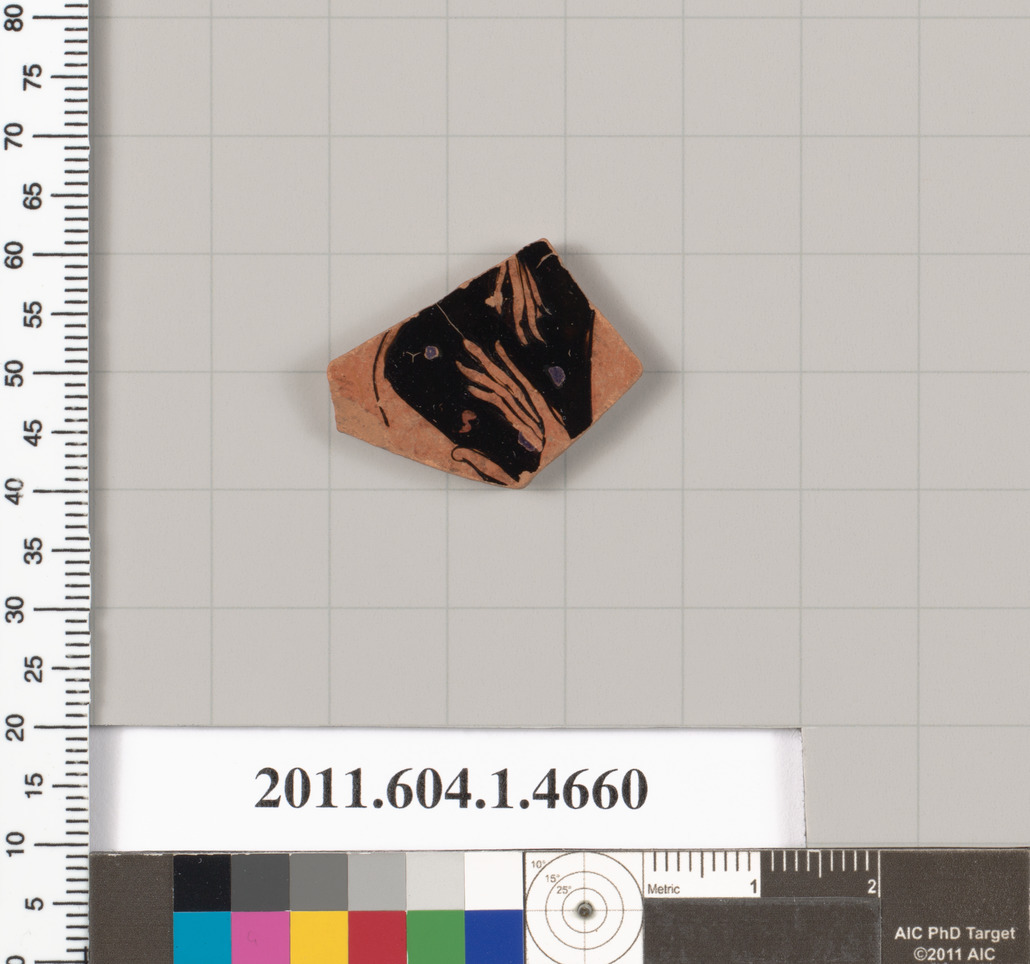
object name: kylix fragment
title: Terracotta fragment of a kylix (drinking cup)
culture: greek, attic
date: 520-500 BCE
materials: terracotta